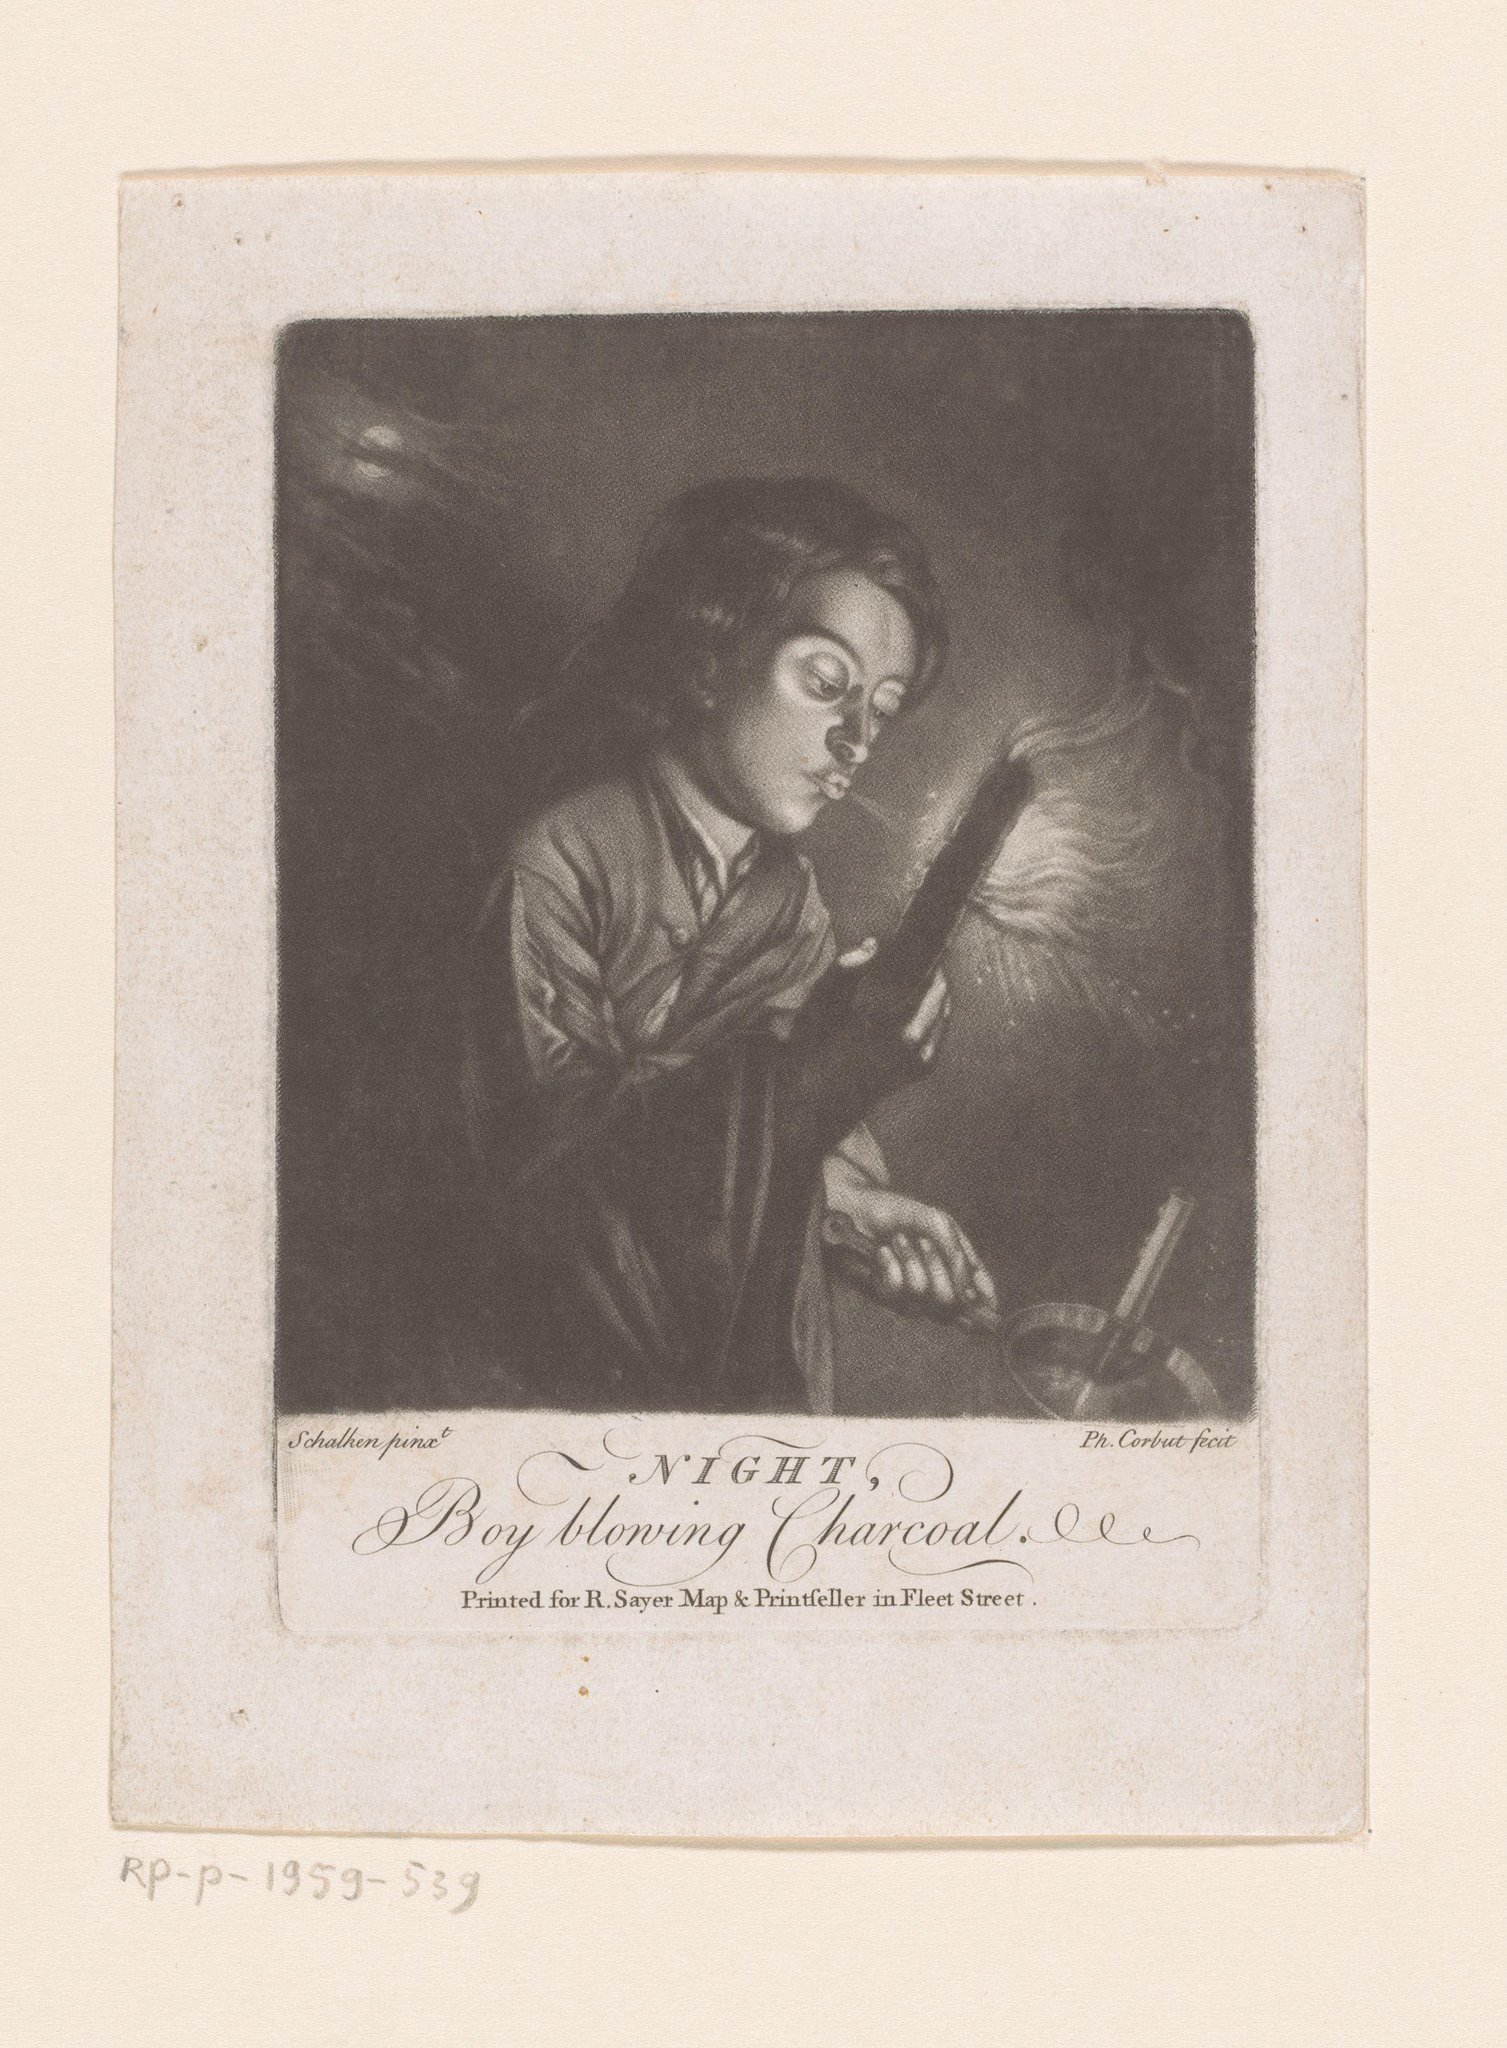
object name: print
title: Jongen blaast tegen een fakkel van houtskool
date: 1748-1768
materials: paper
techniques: mezzotint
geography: london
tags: blowing (stirring up a fire), youth, adolescent, night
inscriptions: collector's mark: Lugt 2228